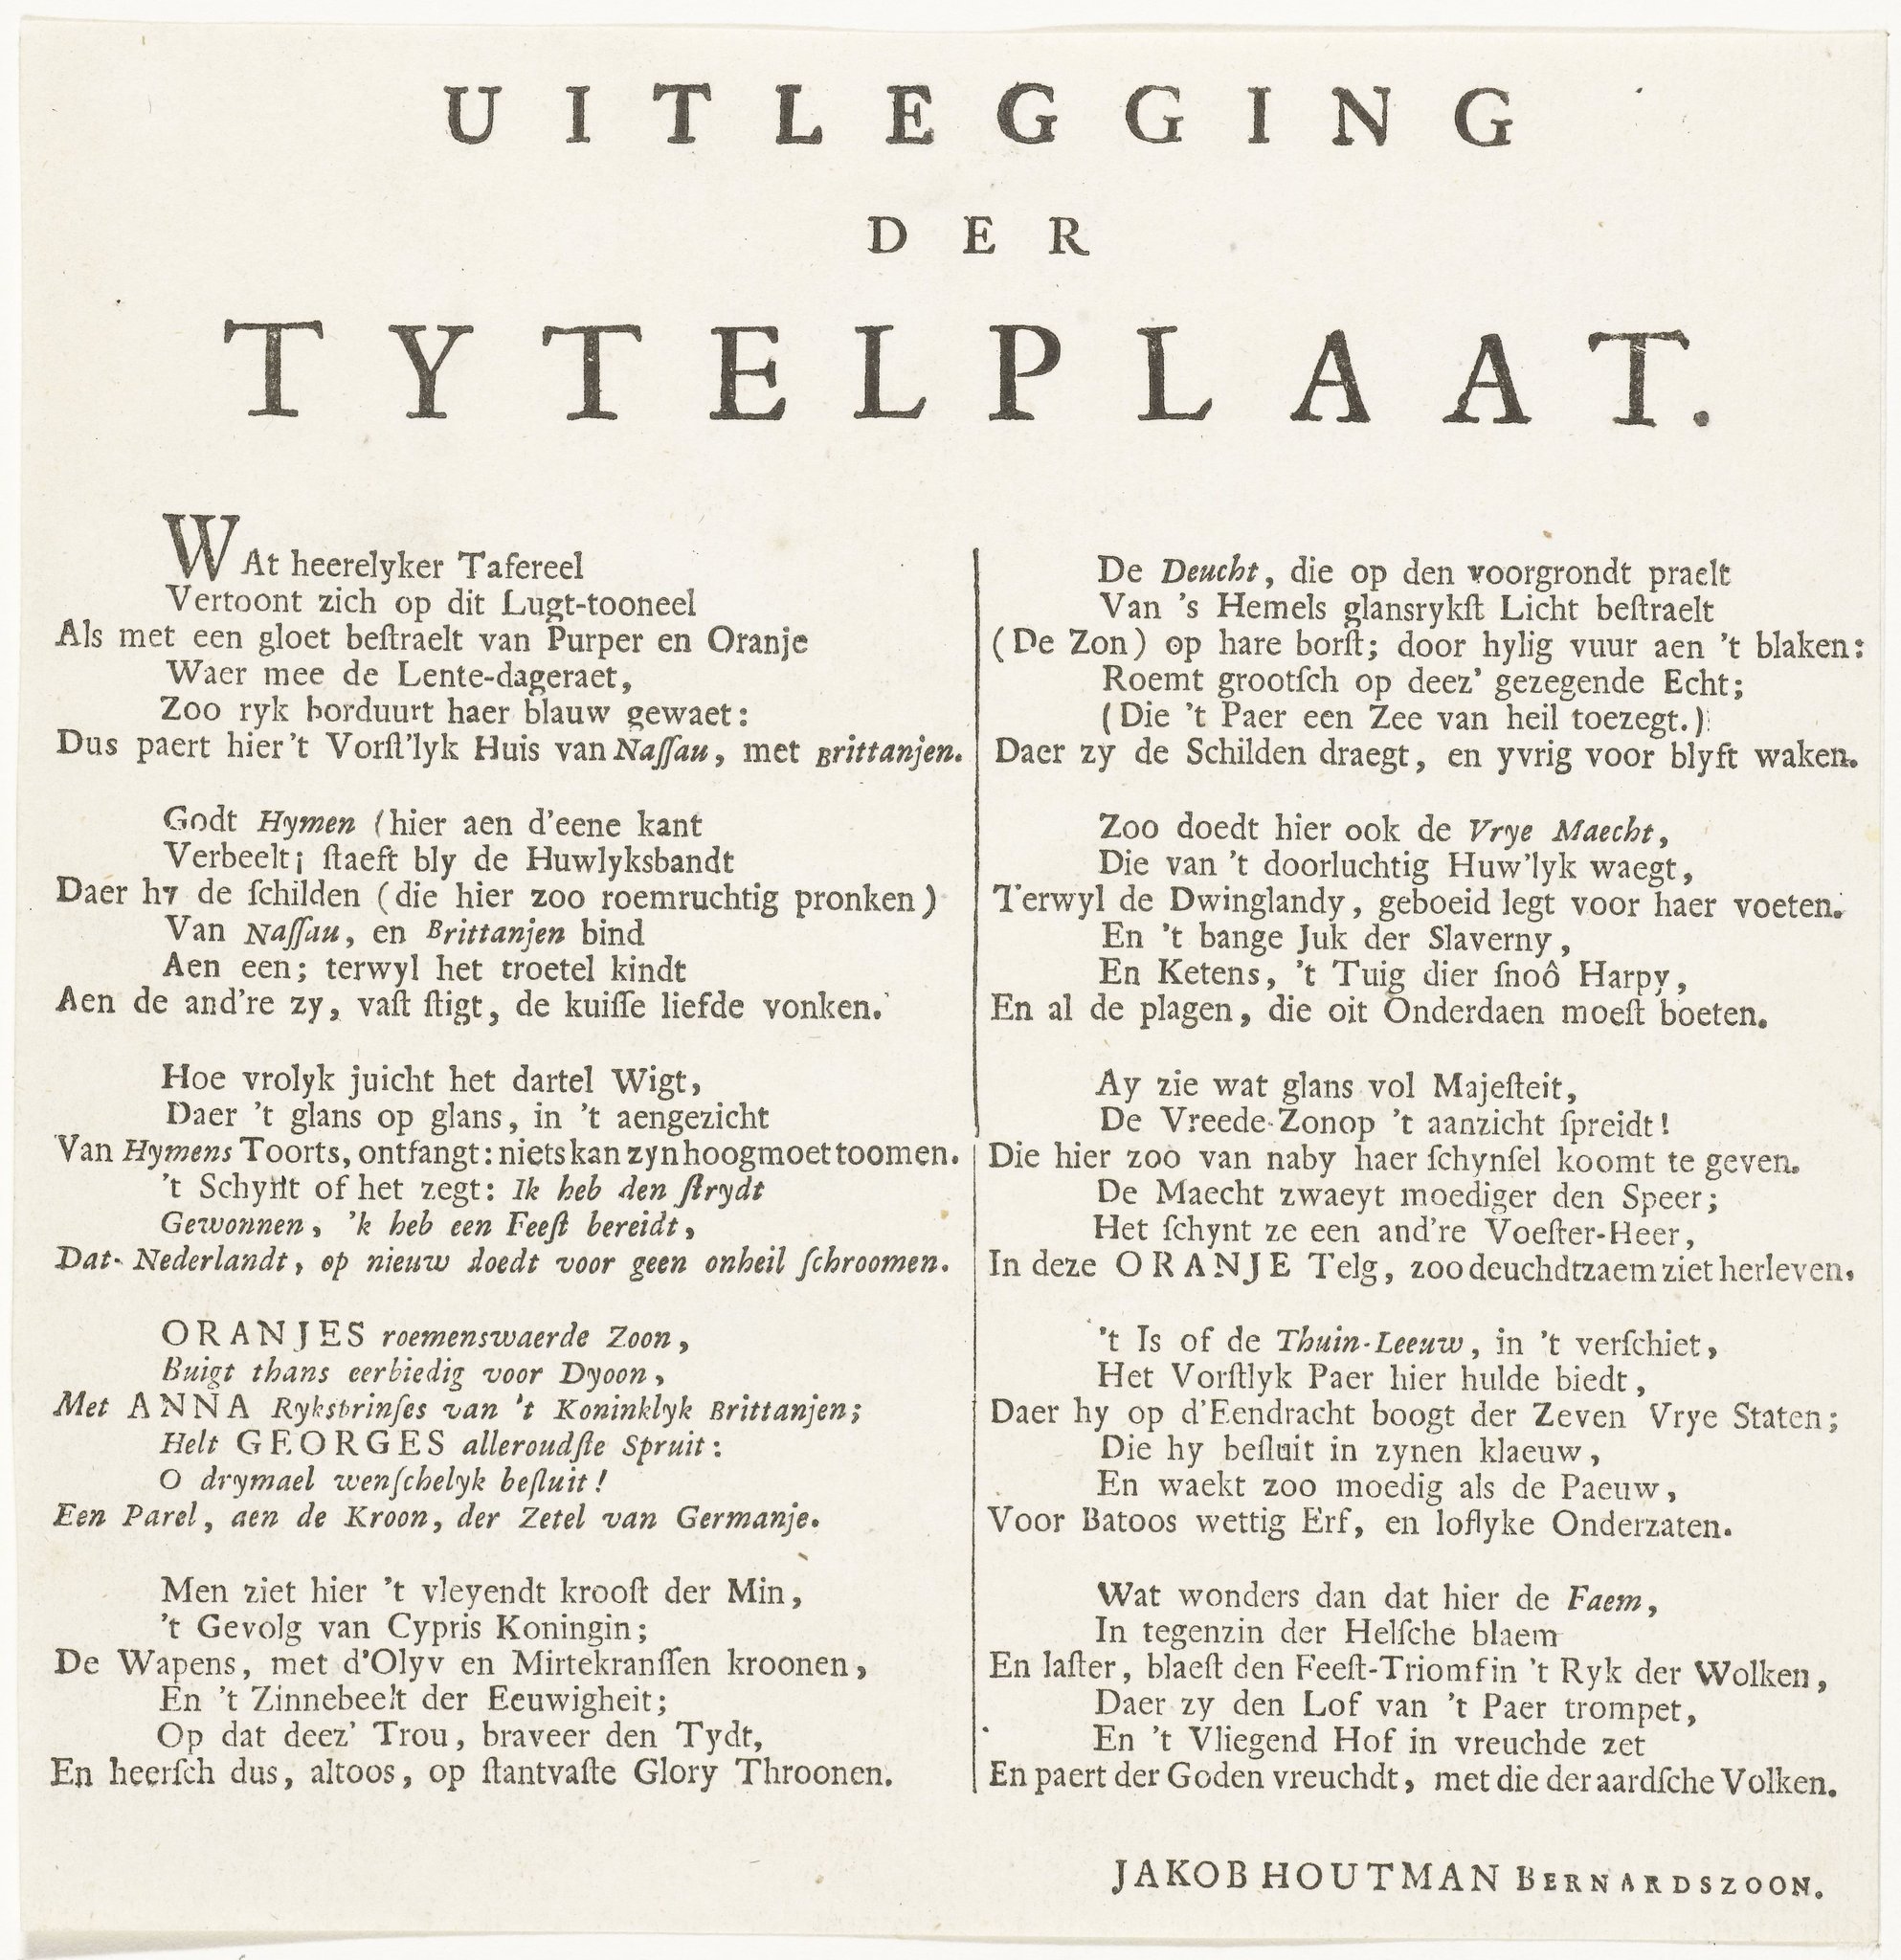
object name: text sheet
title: Uitleg bij de prent met de allegorie op het huwelijk van prins Willem IV en Anna van Engeland, 1734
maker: jacob houtman bernardszoon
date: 1734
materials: paper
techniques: letterpress printing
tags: willem iv (prins van oranje-nassau), the hague, anna van hannover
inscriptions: collector's mark: Lugt 2228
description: Tekstblad met een uitleg op rijm van de voorstelling van de prent met de allegorie op het huwelijk van prins Willem IV en prinses Anna van Engeland op 25 maart 1734.